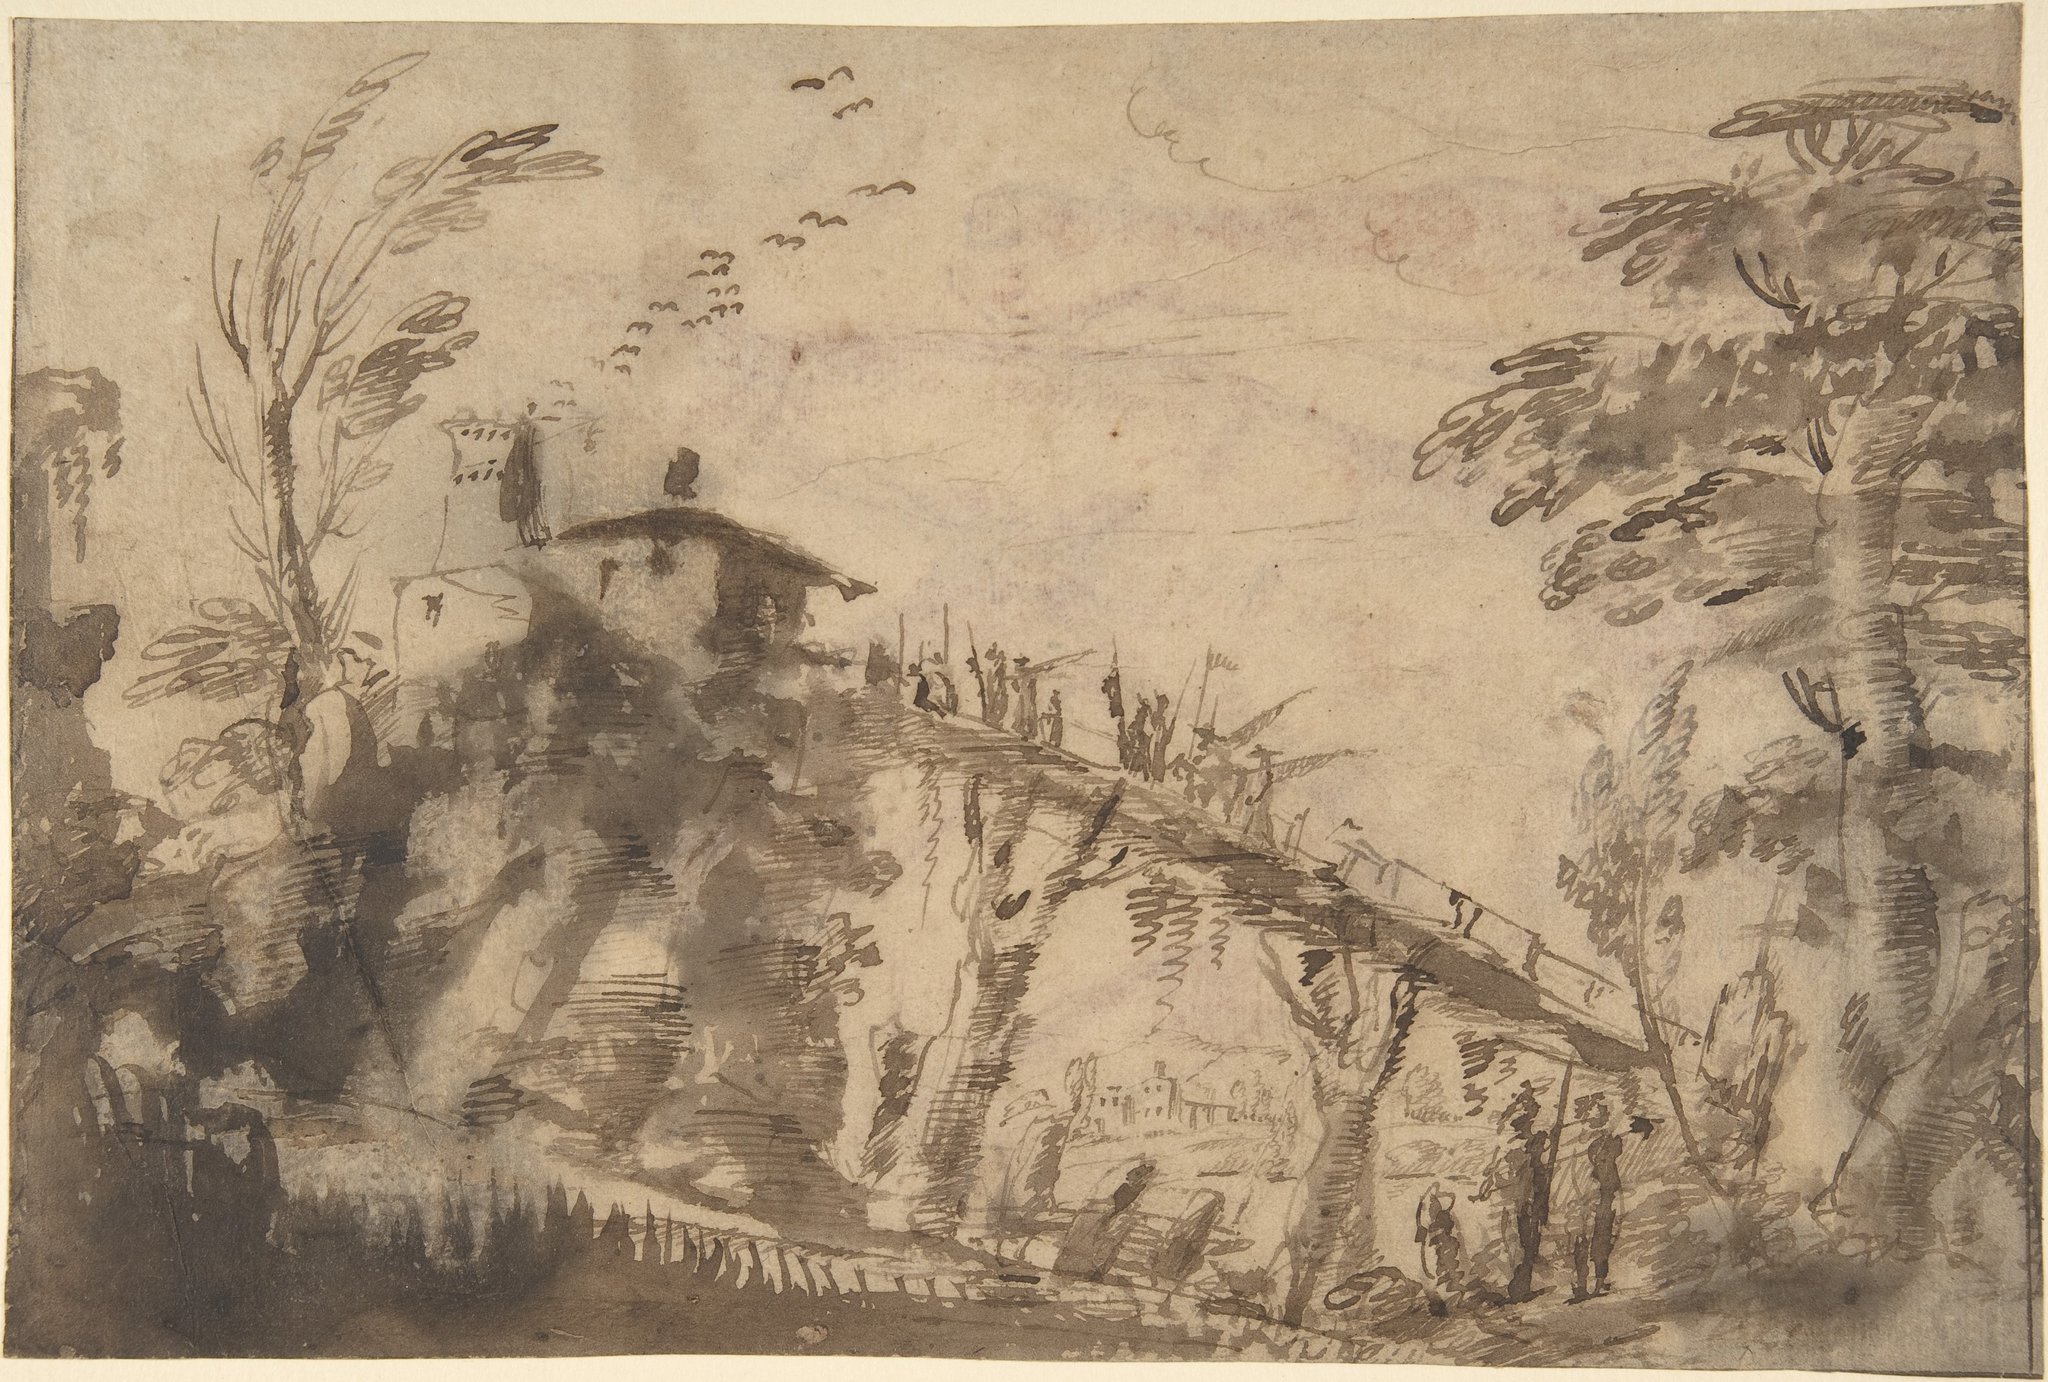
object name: drawing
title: Landscape with Figures Crossing a Bridge (recto); Study of a Nude Male, Study of Legs, Study of Head in Profile to the Right (verso)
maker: anonymous, italian, roman-bolognese, 17th century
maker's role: artist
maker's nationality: italian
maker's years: 1600-1700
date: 1601-1700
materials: chalk, ink, paper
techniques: brush, drawing, highlighting, pen, wash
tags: bridges,heads,male nudes,landscapes,trees